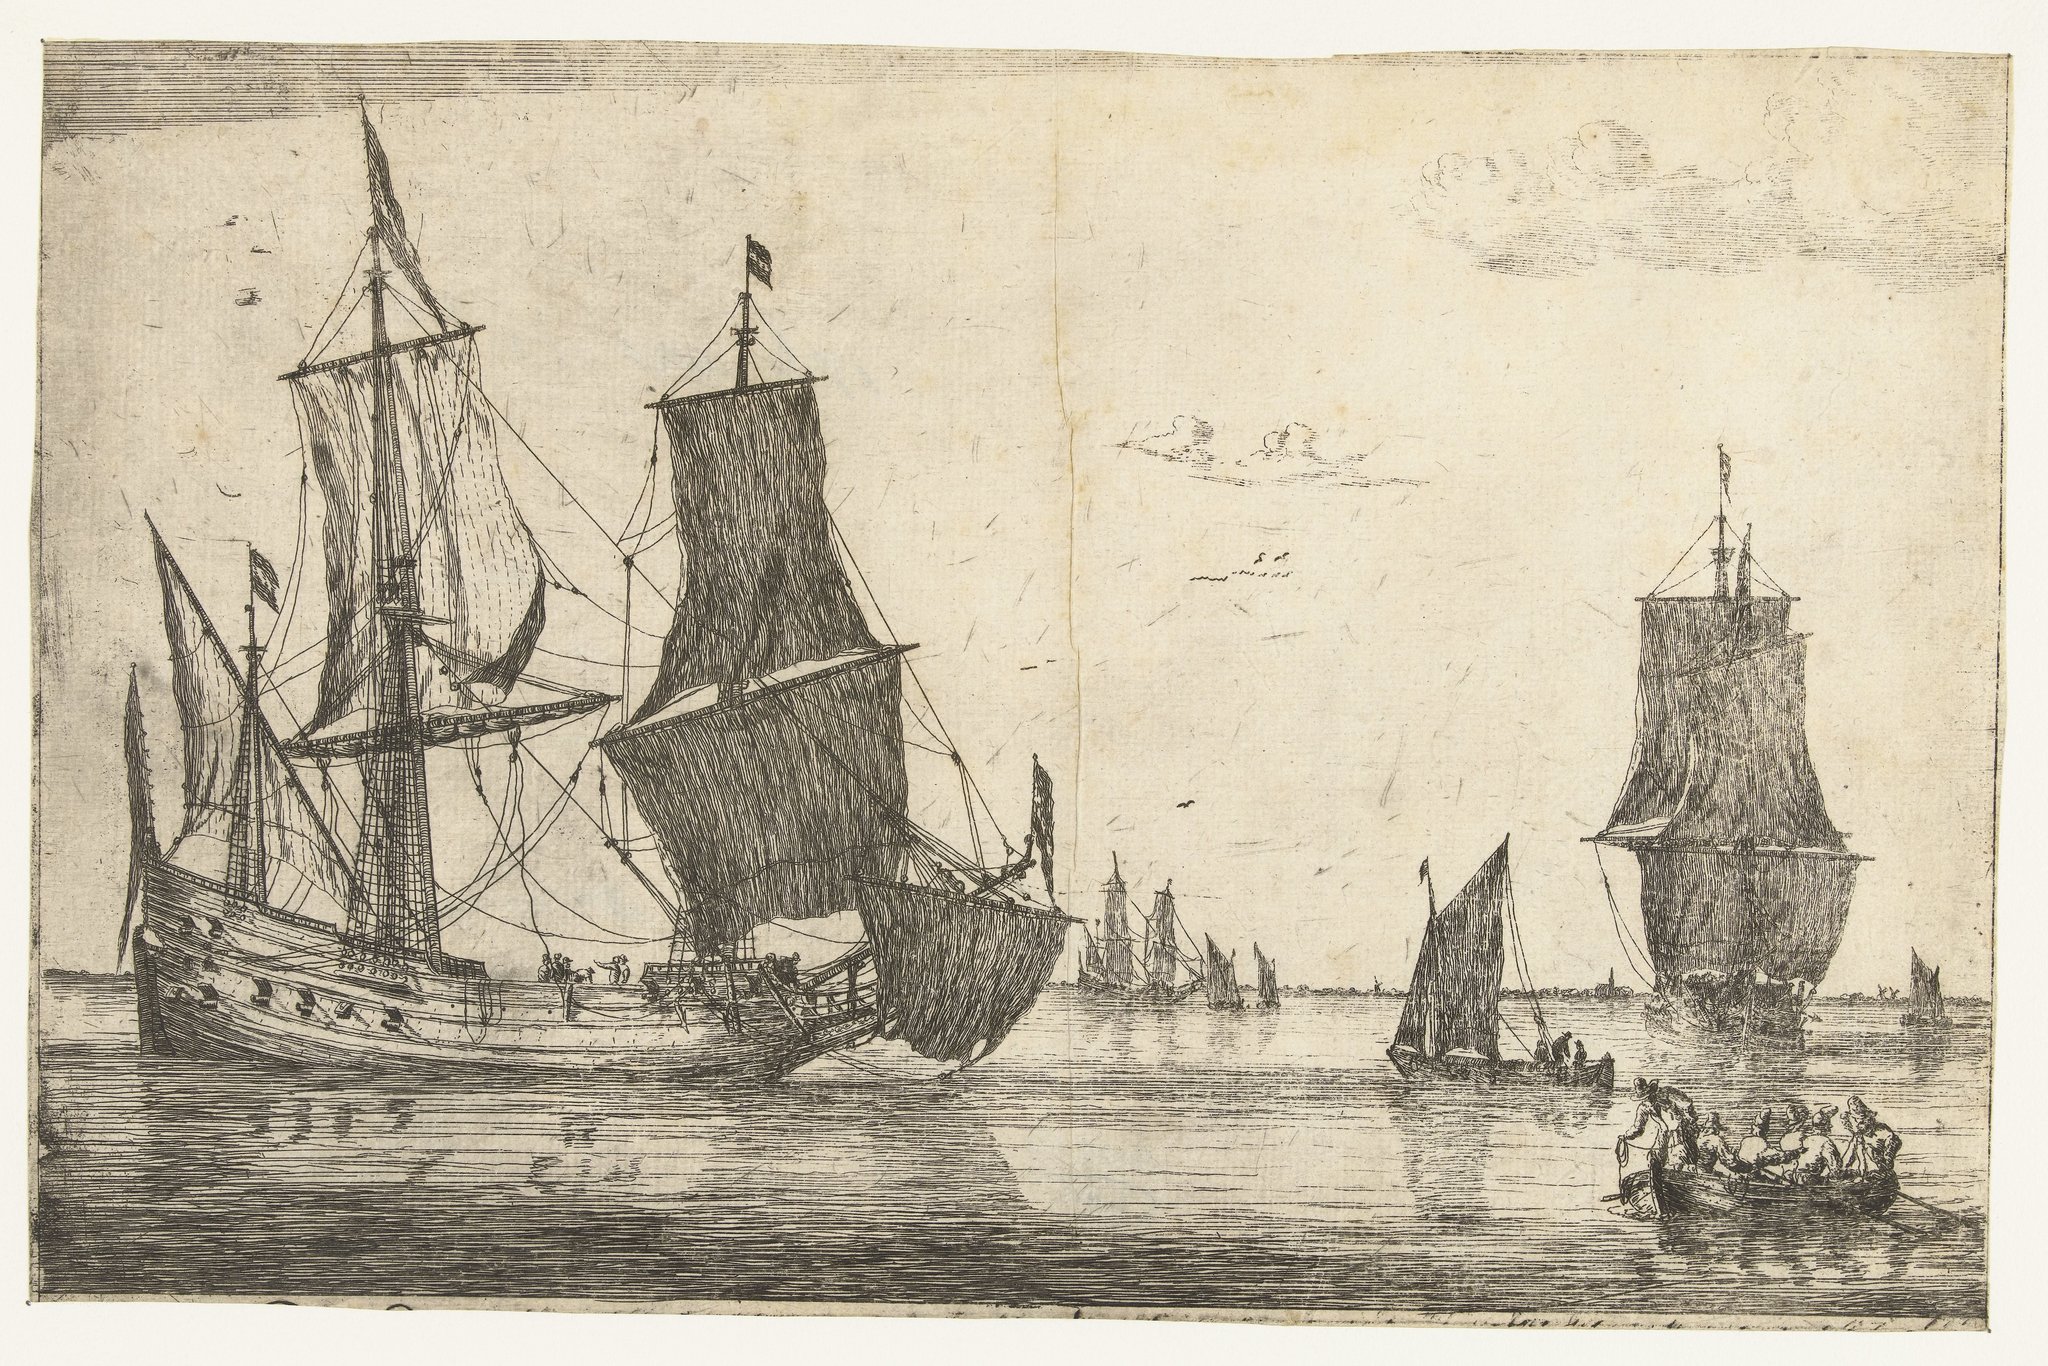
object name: print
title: Dertien scènes met schepen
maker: reinier nooms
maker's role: draughtsman, painter, print maker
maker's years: 1623-1664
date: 1650-1664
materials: paper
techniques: etching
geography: netherlands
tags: sailing-ship, sailing-boat (with name)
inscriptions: collector's mark: Lugt 2228a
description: Binnenwater met een groot fluitschip van de zijkant gezien, een roeiboot en een aantal andere zeilschepen.